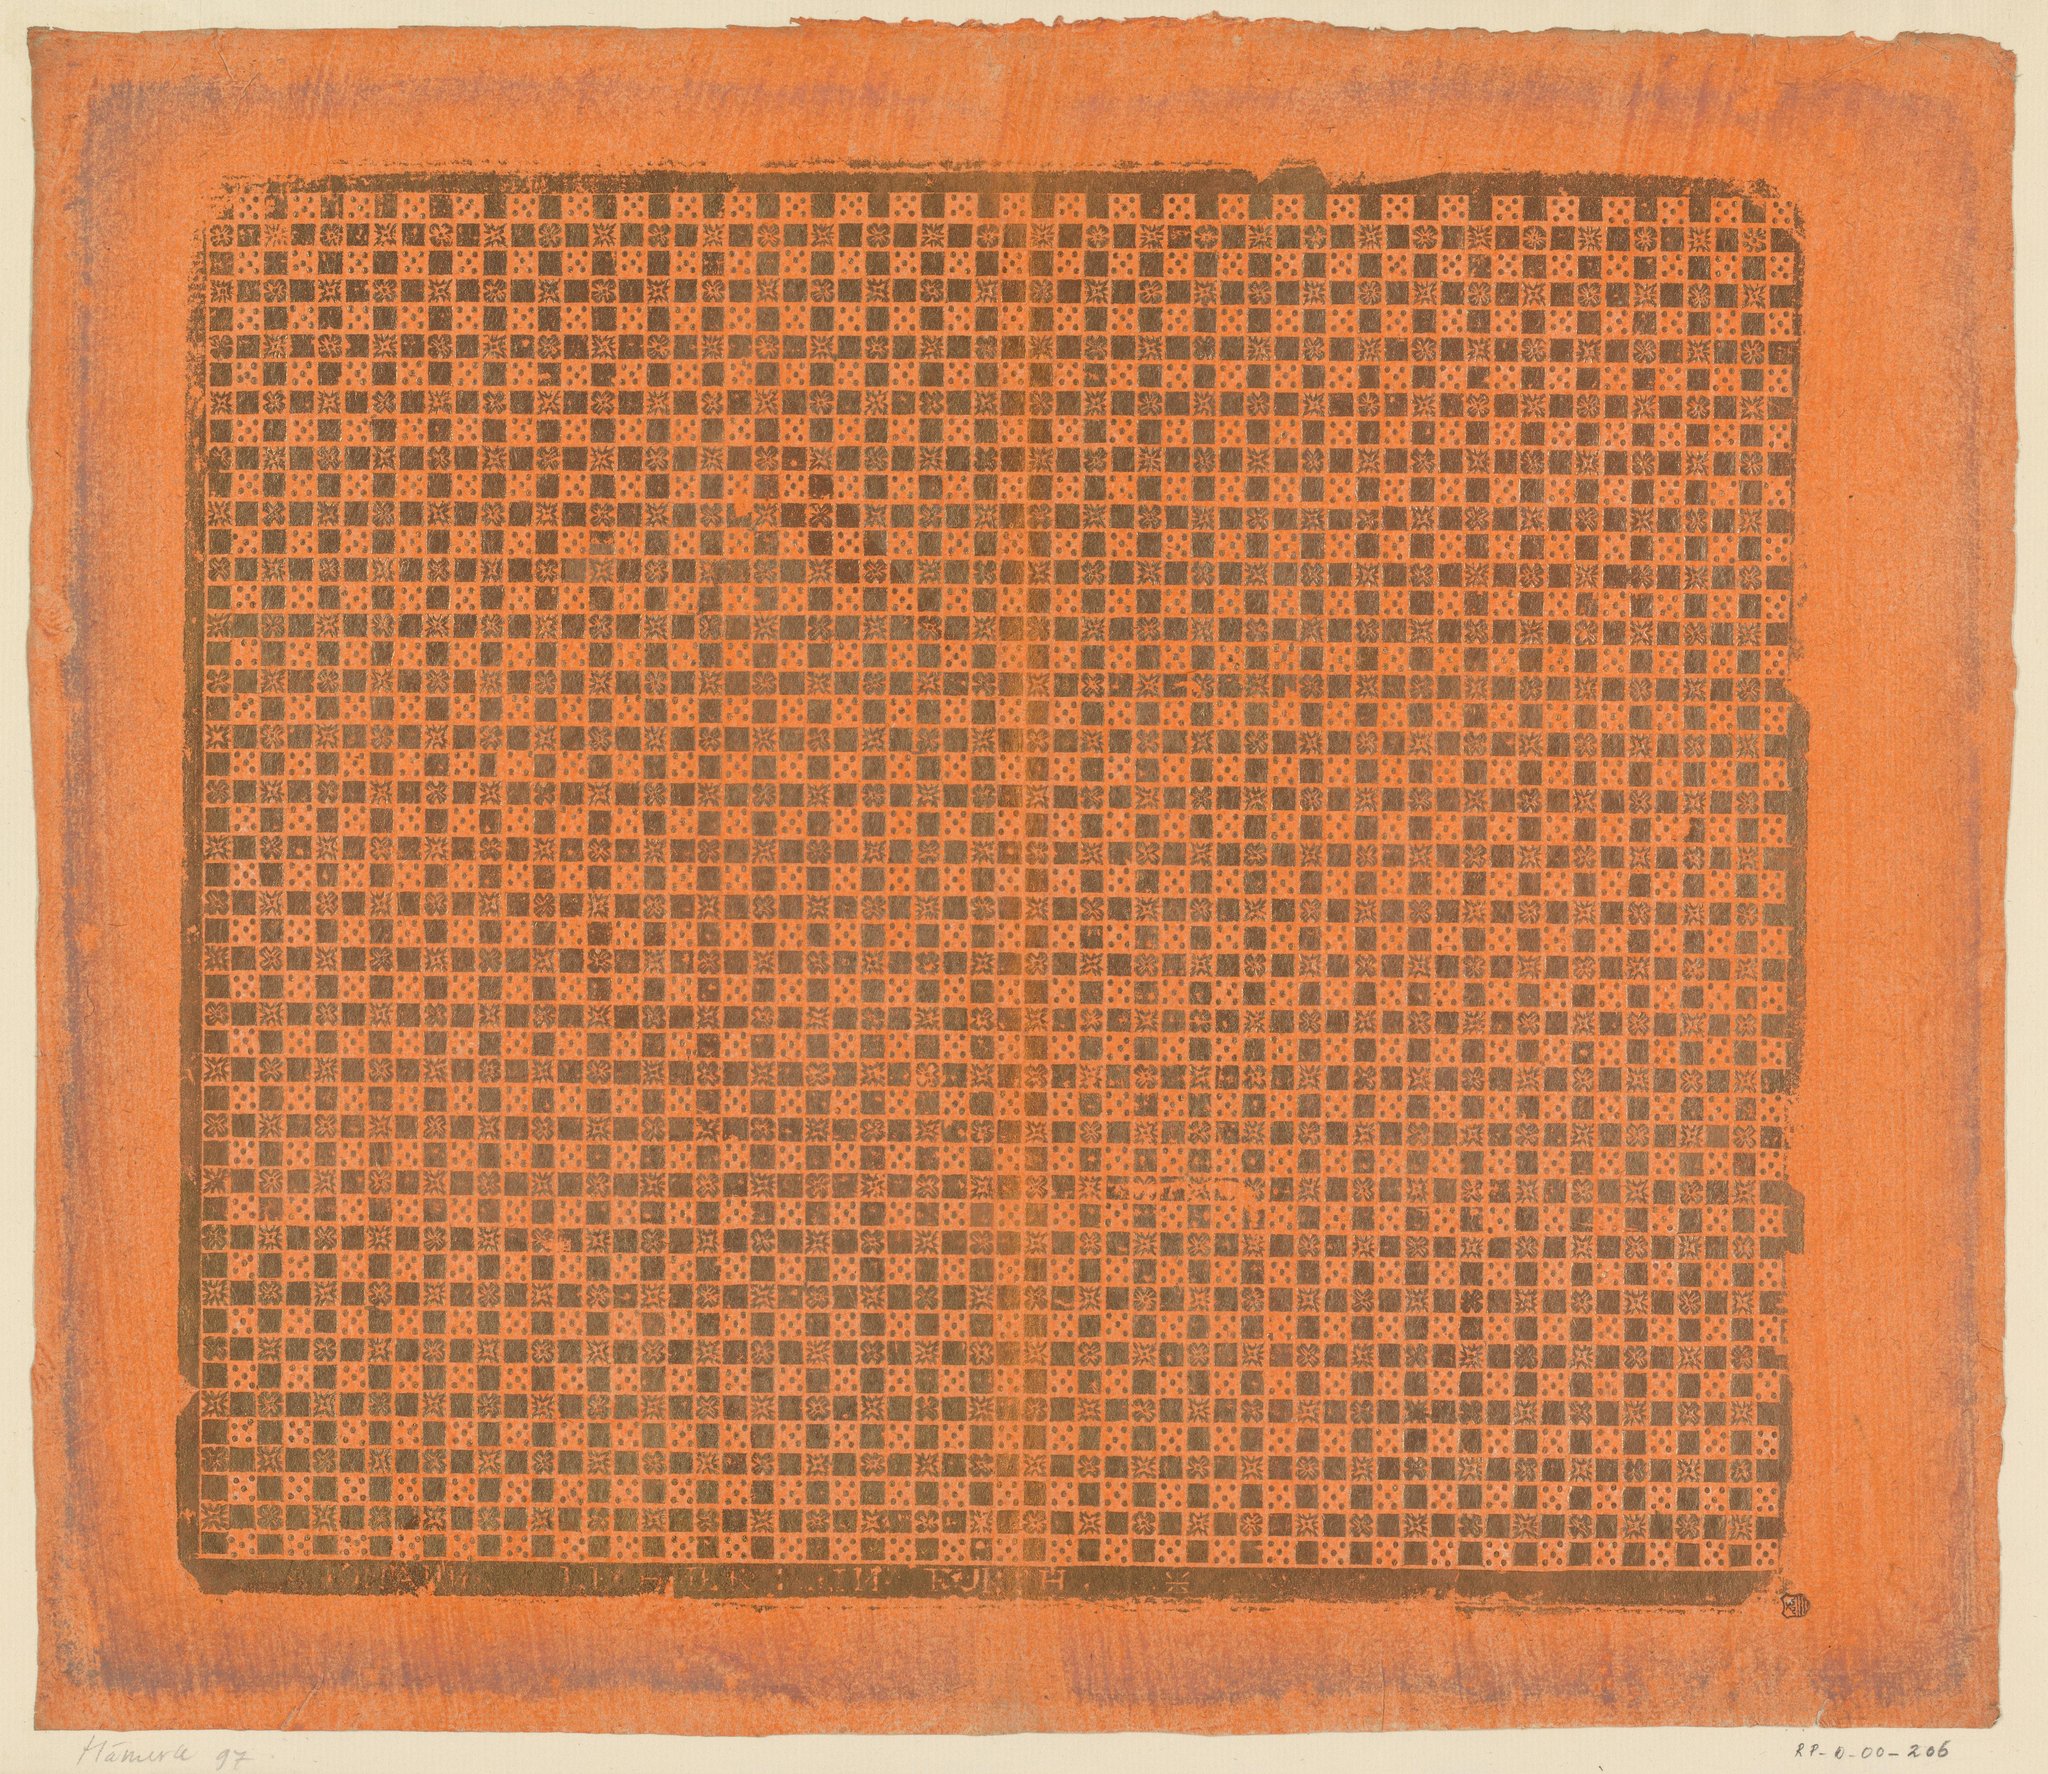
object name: brocade paper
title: Blad met schaakbordpatroon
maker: johann lechner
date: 1790-1839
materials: gold leaf, paint, paper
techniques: relief print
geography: furth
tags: ornament ~ geometric motifs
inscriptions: collector's mark: Lugt 2760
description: Blad met schaakbordpatroon met afwisselend vierkant in geheel goud, twee soorten rozetten en dobbelsteen vijf.